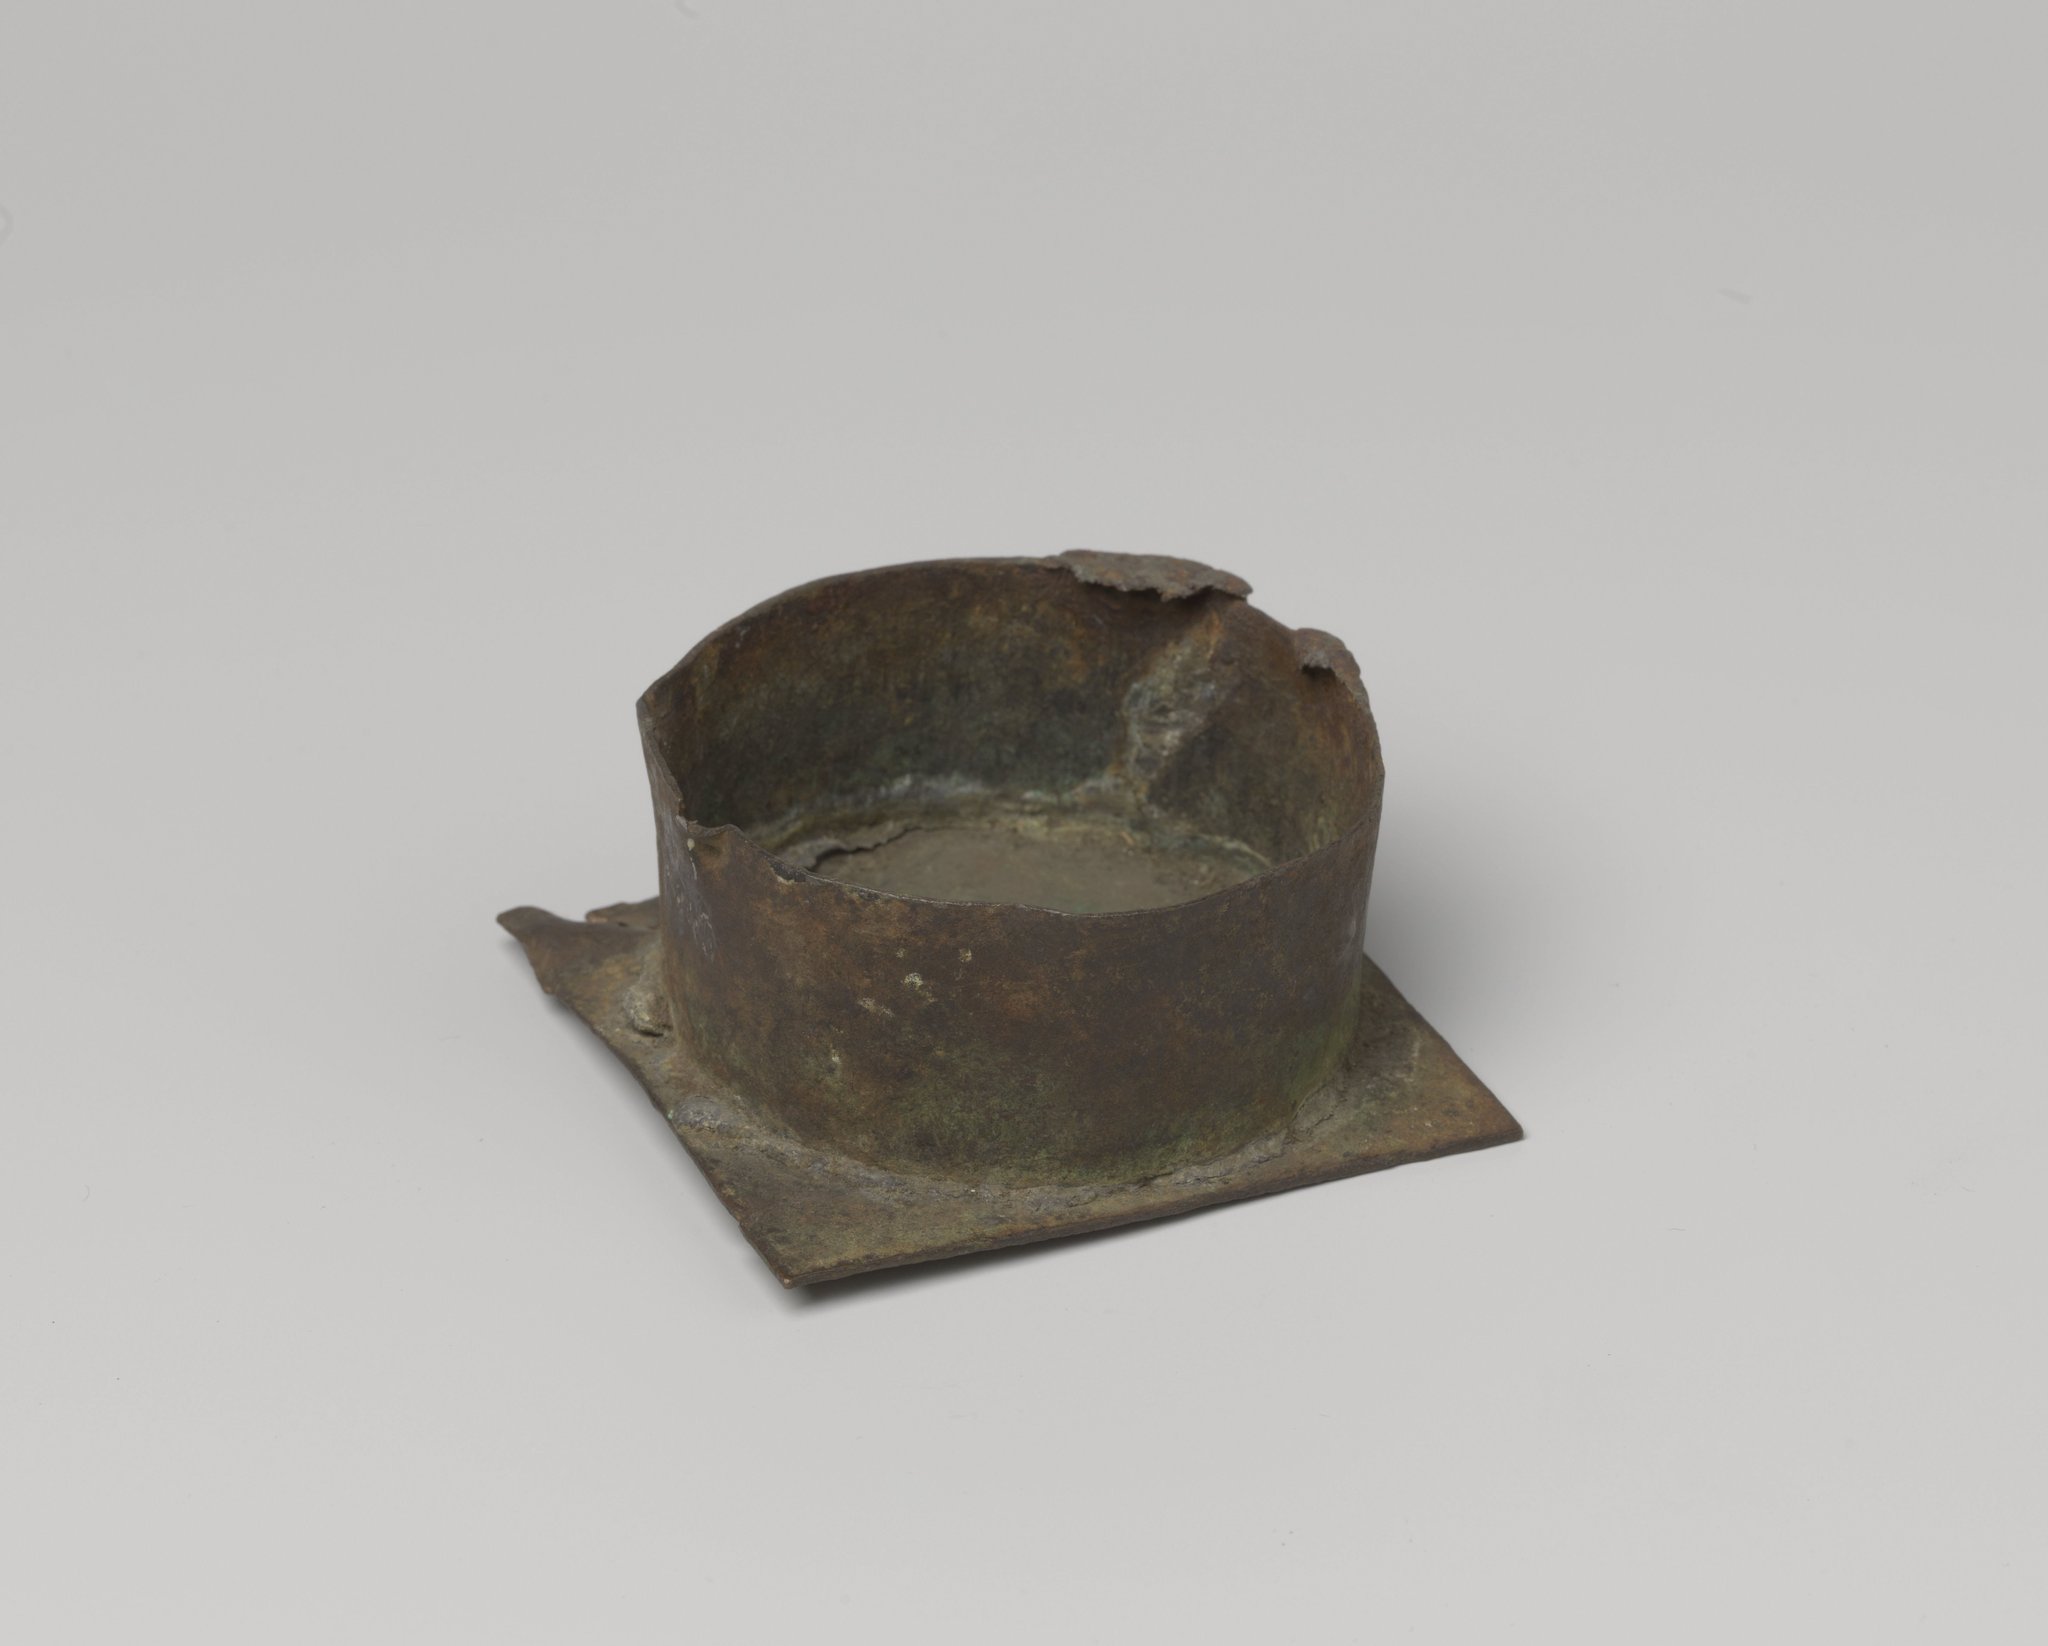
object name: container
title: Bak bestaande uit een vierkante basis waarop een cirkelvormige opstaande wand is gesoldeerd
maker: Anonymous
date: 1590-1596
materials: copper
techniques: soldering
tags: willem barendsz., amsterdam, jacob van heemskerck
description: Bak bestaande uit een vierkante basis waarop een cirkelvormige opstaande wand is gesoldeerd. Het is onduidelijk of het hier een bakje of de bodem van een spionterbakje betreft?